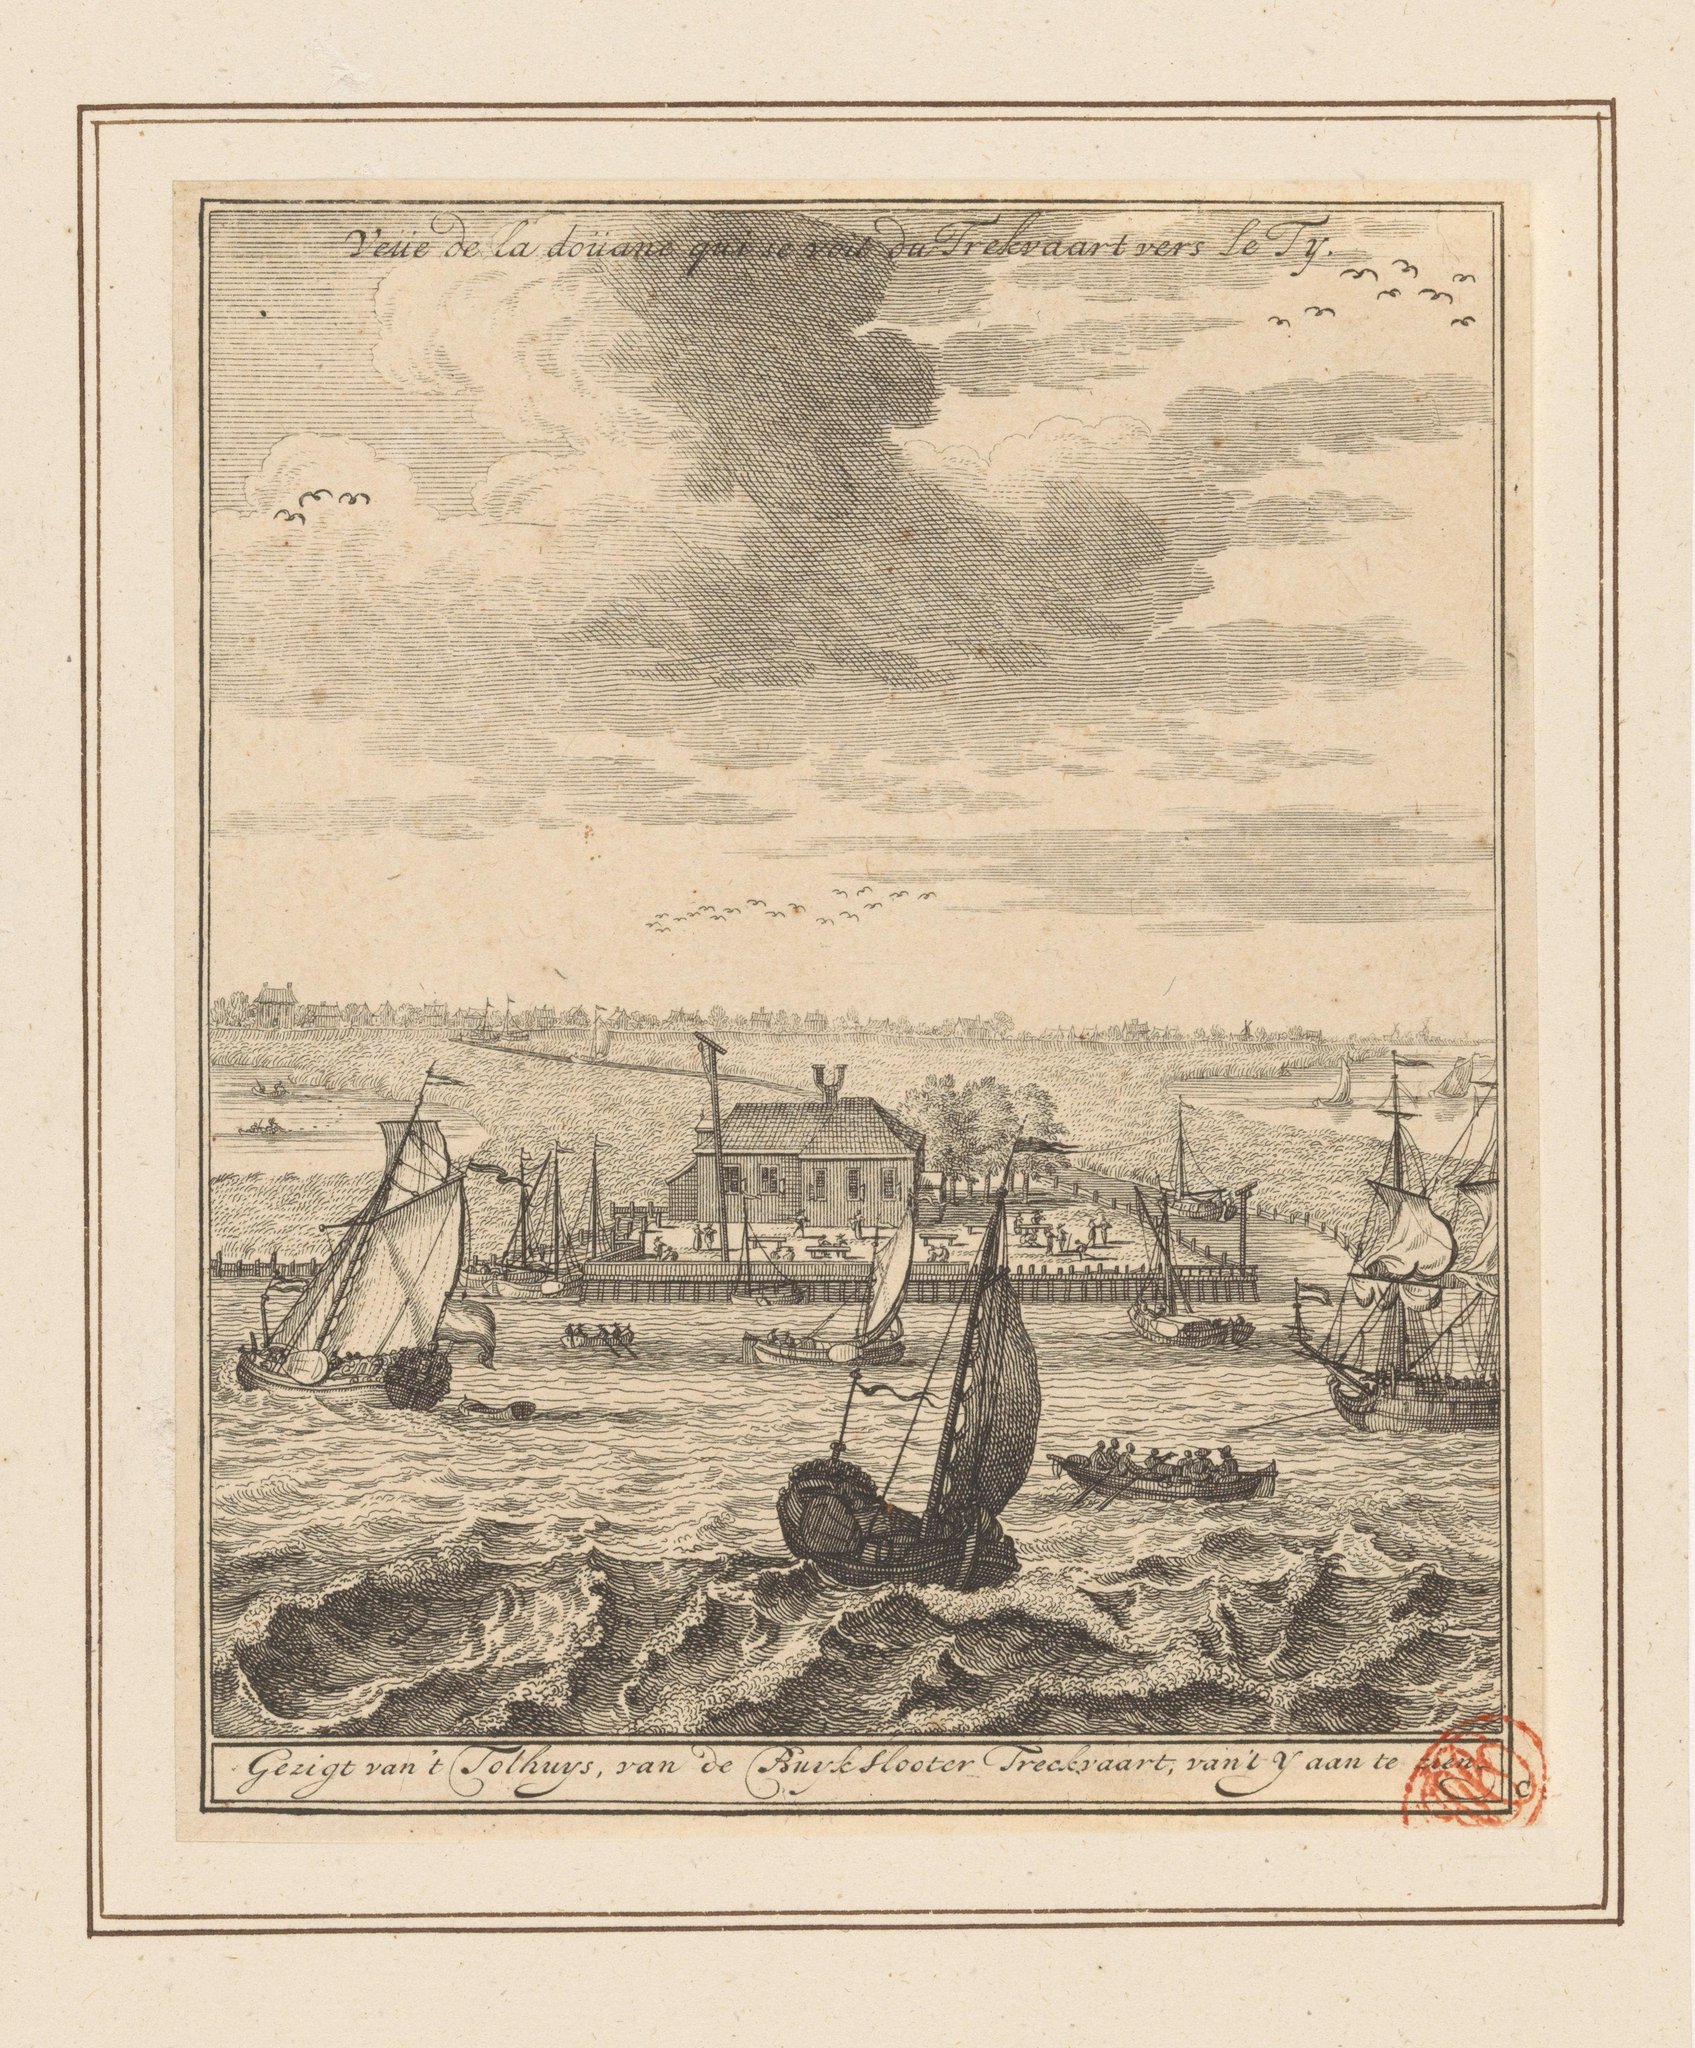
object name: print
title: Gezicht op het tolhuis van de Buikslotervaart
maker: Anonymous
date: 1660-1770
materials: paper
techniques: engraving, etching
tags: toll gate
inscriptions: collector's mark: Lugt 195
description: Gezicht op het tolhuis van de Buikslotervaart, gezien vanaf het IJ.